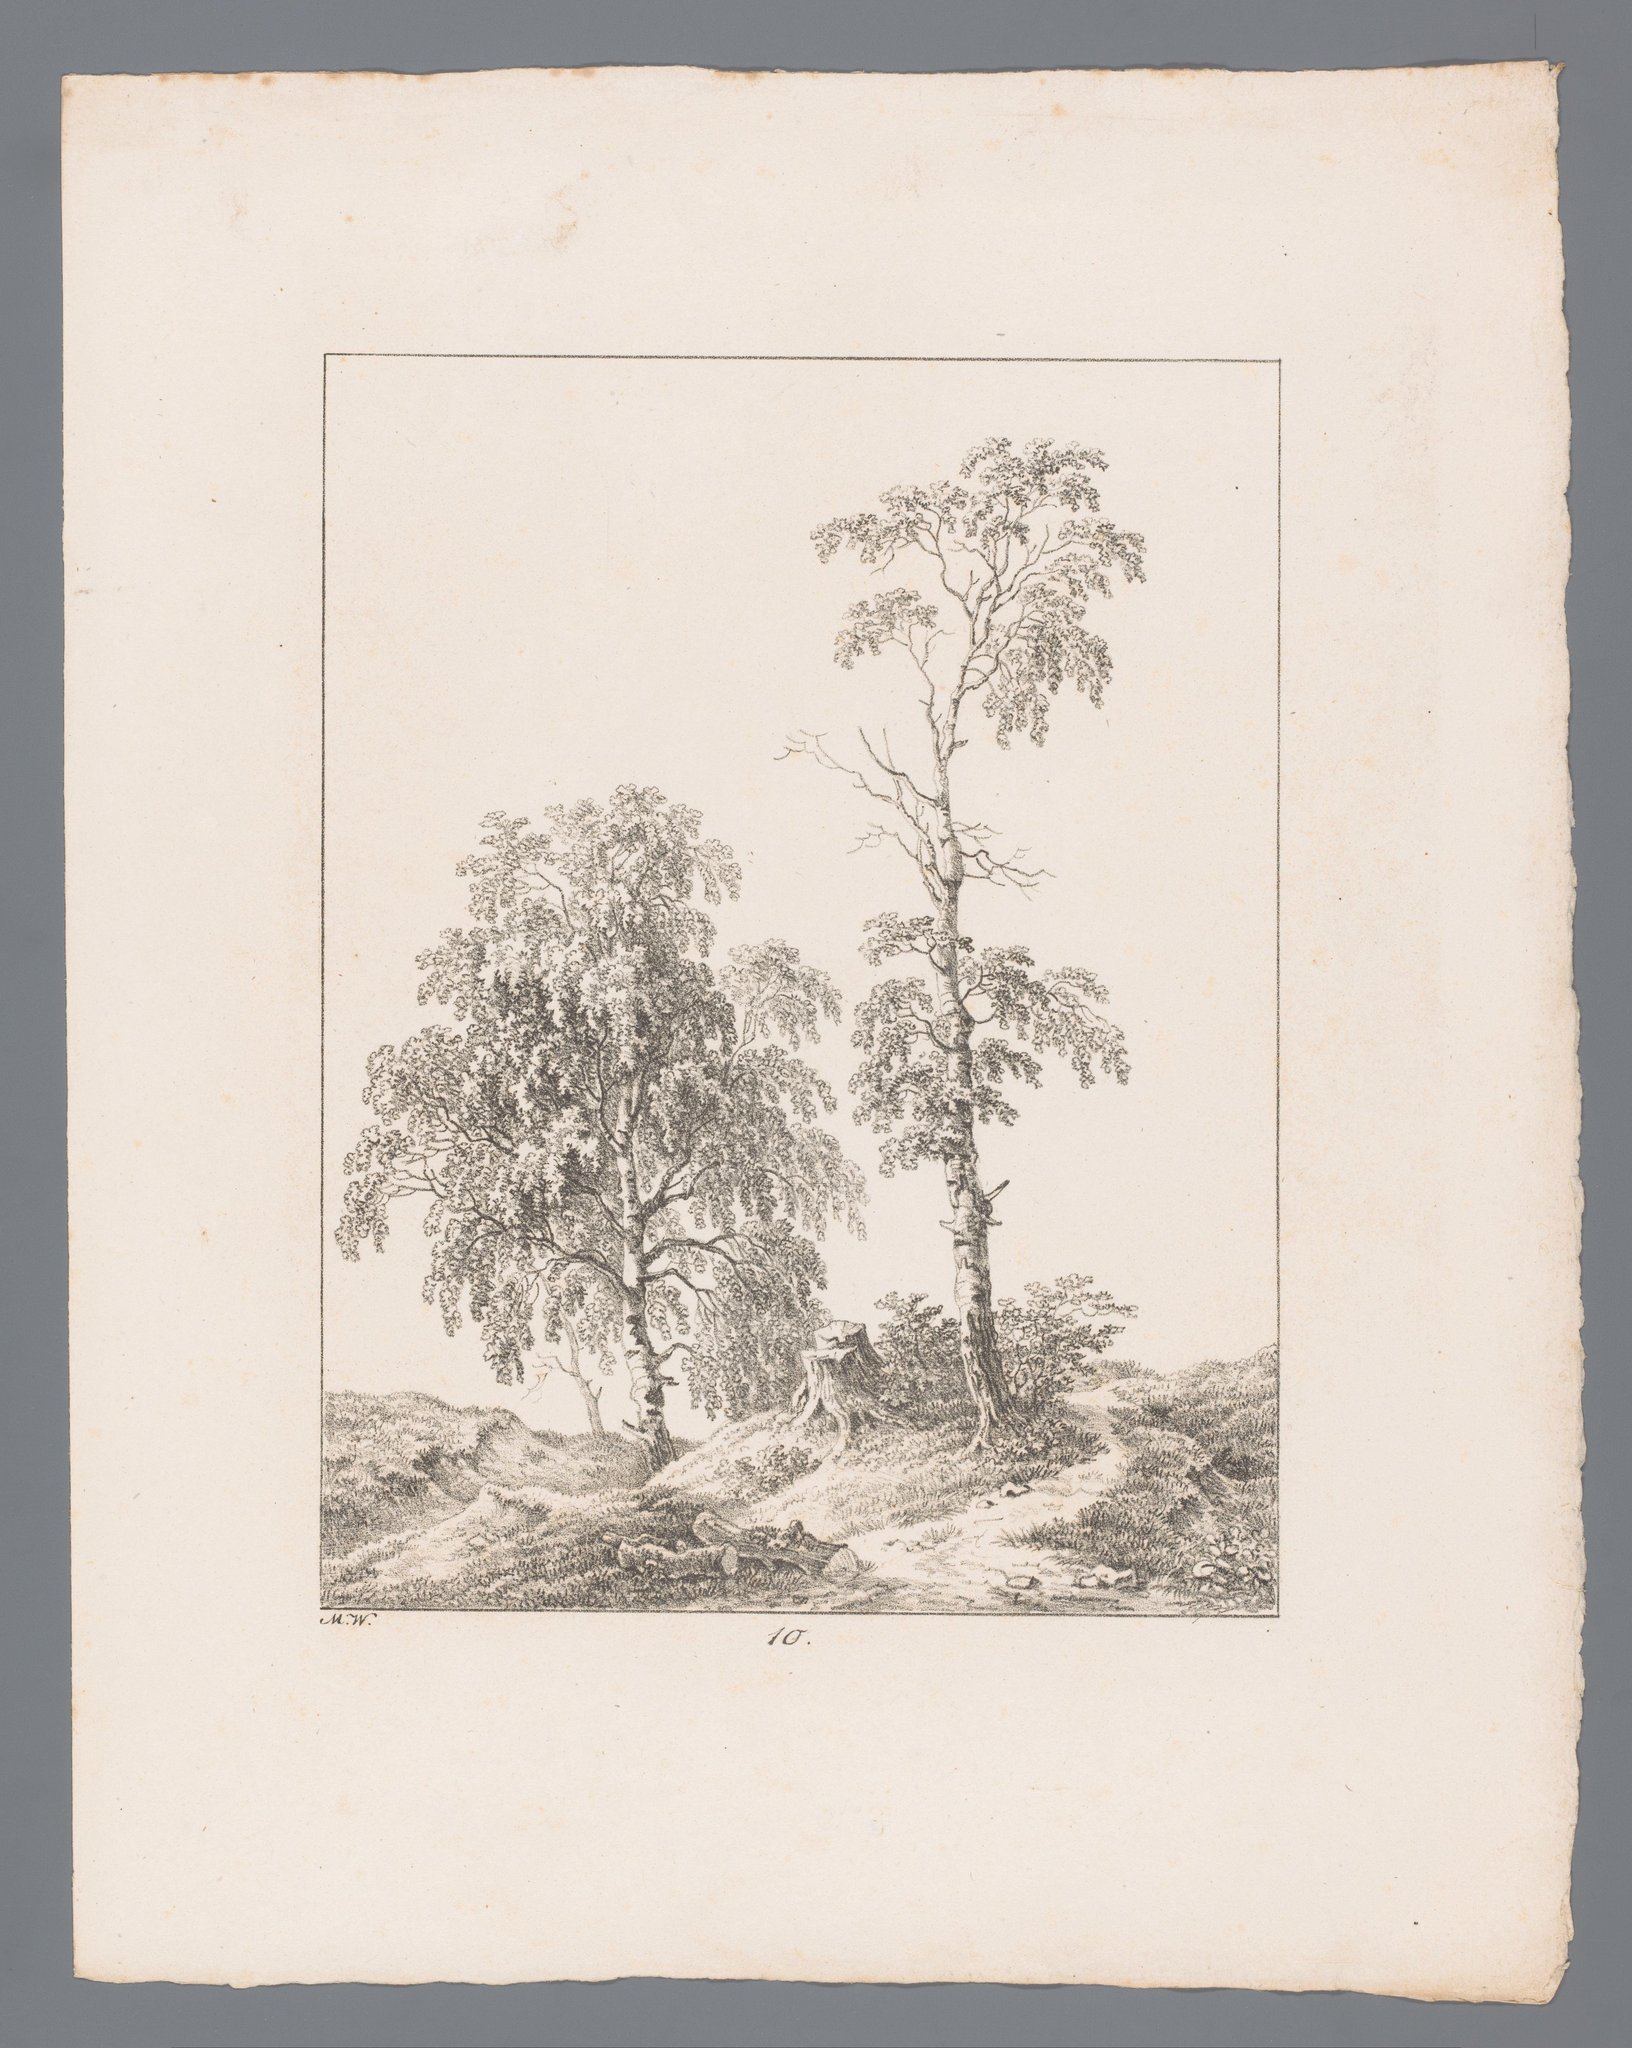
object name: print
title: Vorlagen für Landschaft-Zeichner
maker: max josef wagenbauer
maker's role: print maker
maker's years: 1774-1829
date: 1823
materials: paper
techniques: lithograph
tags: low hill country, trees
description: Onderdeel van een tweedelige serie waarvan het eerste deel bestaat uit een titelprent en twintig voorstellingen van takken, bladeren, bomen en landschappen.